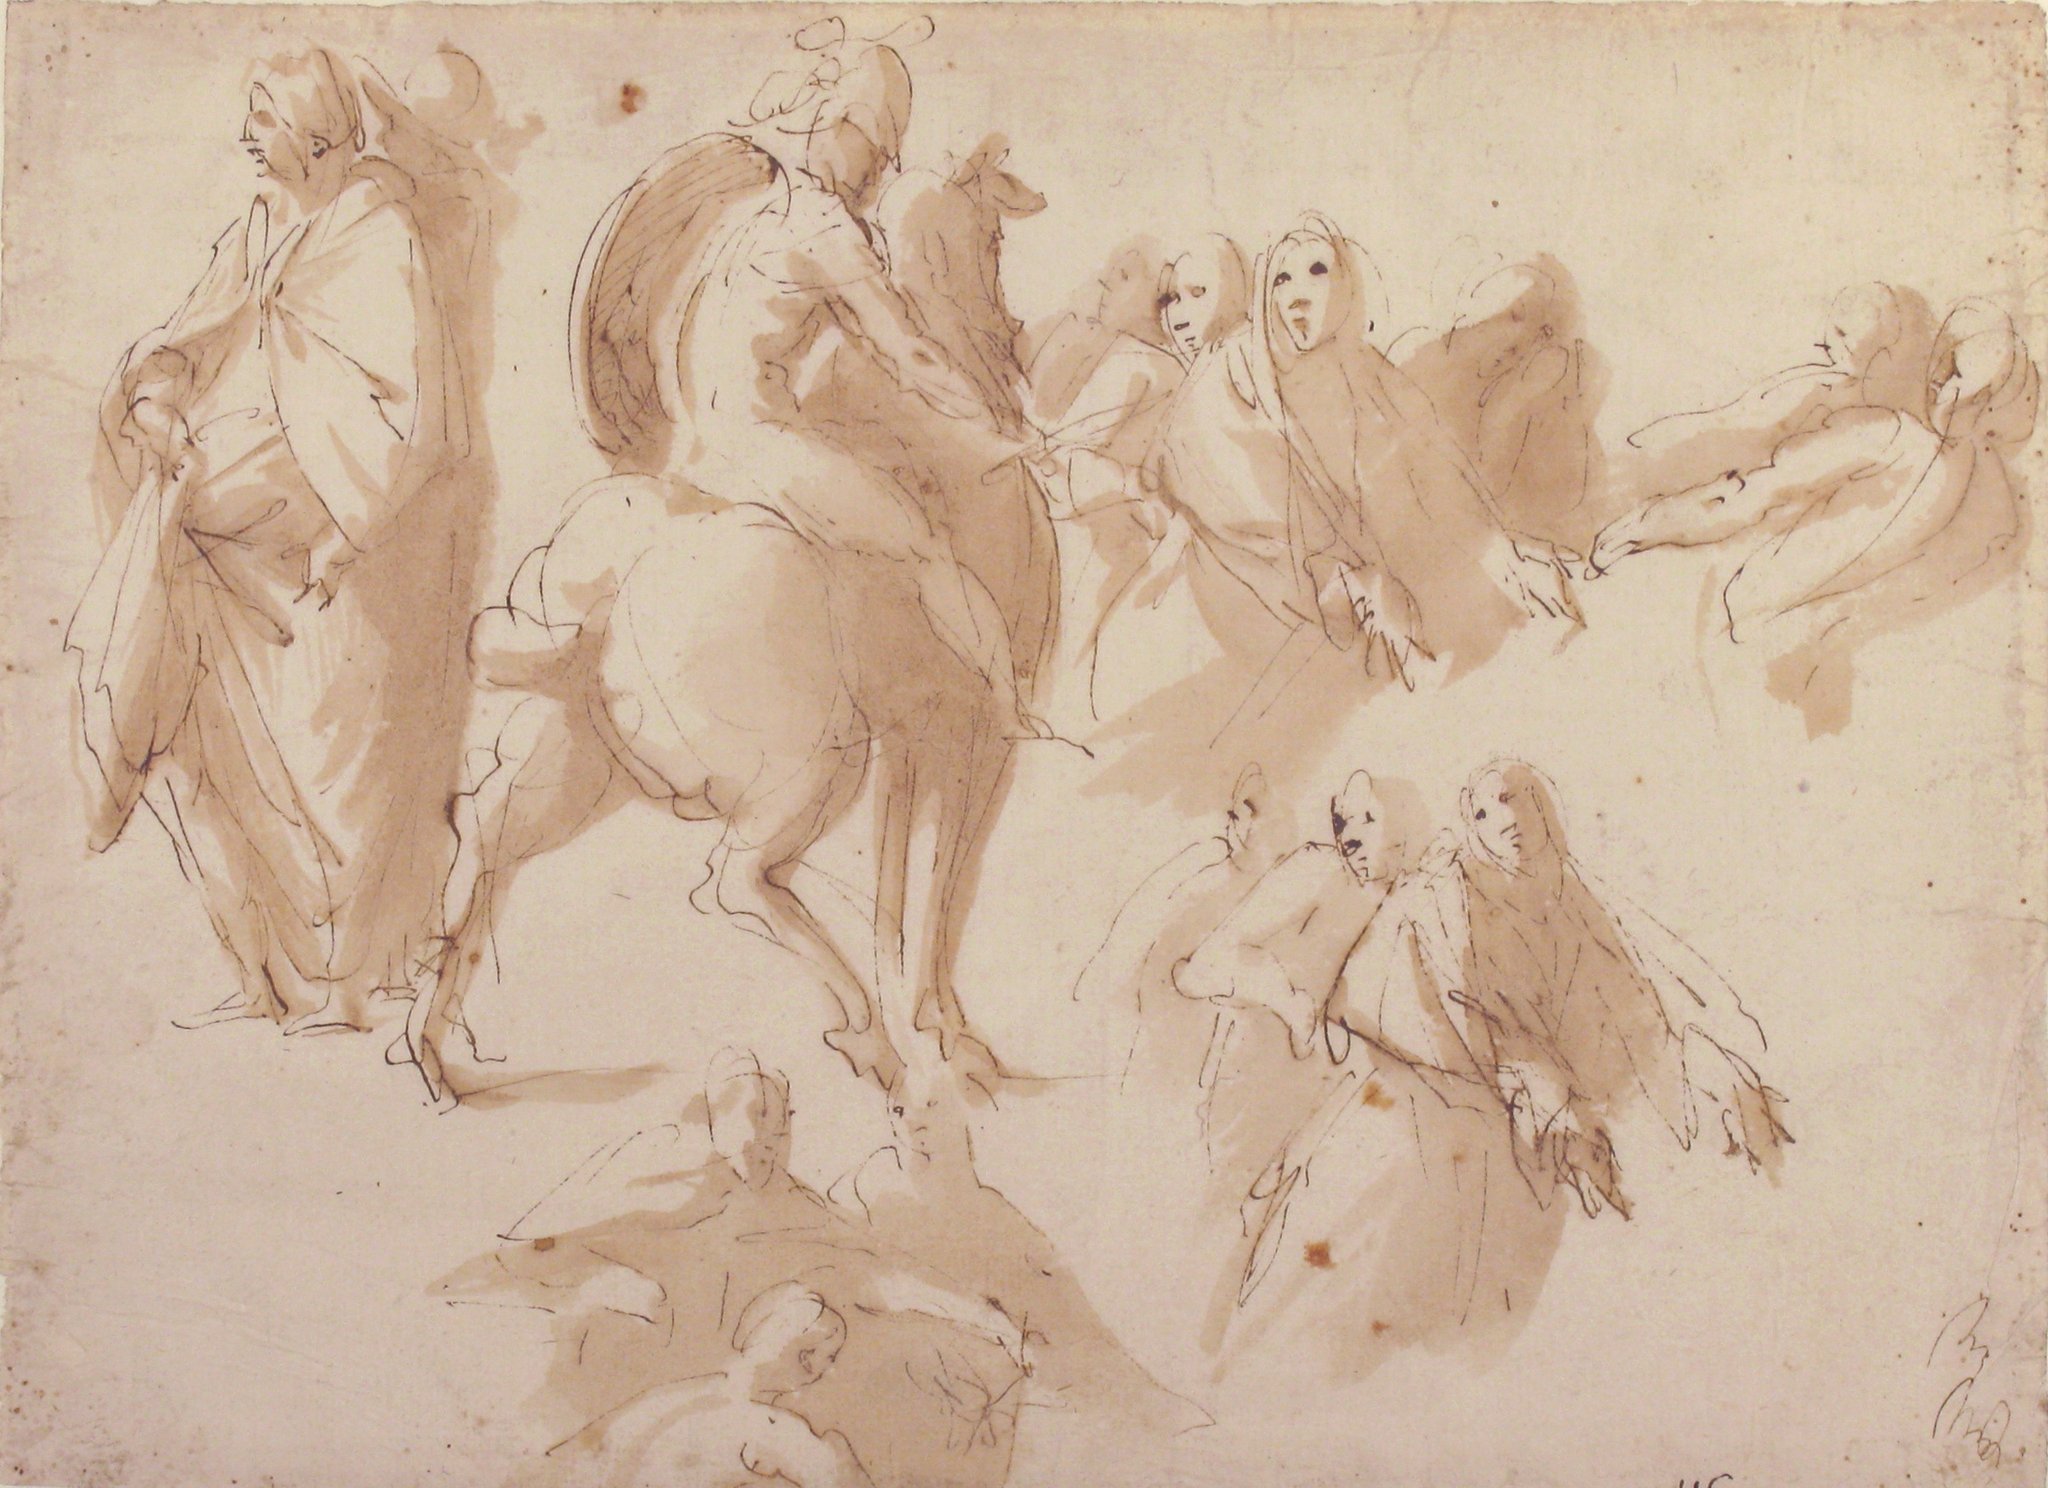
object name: drawing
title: Figure Studies: Warrior on Horseback, and Groups of Standing Female Figures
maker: francesco curia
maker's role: artist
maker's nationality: italian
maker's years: 1565-1608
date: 1565-1608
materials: ink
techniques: brush, pen, wash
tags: soldiers,shields,women,horses